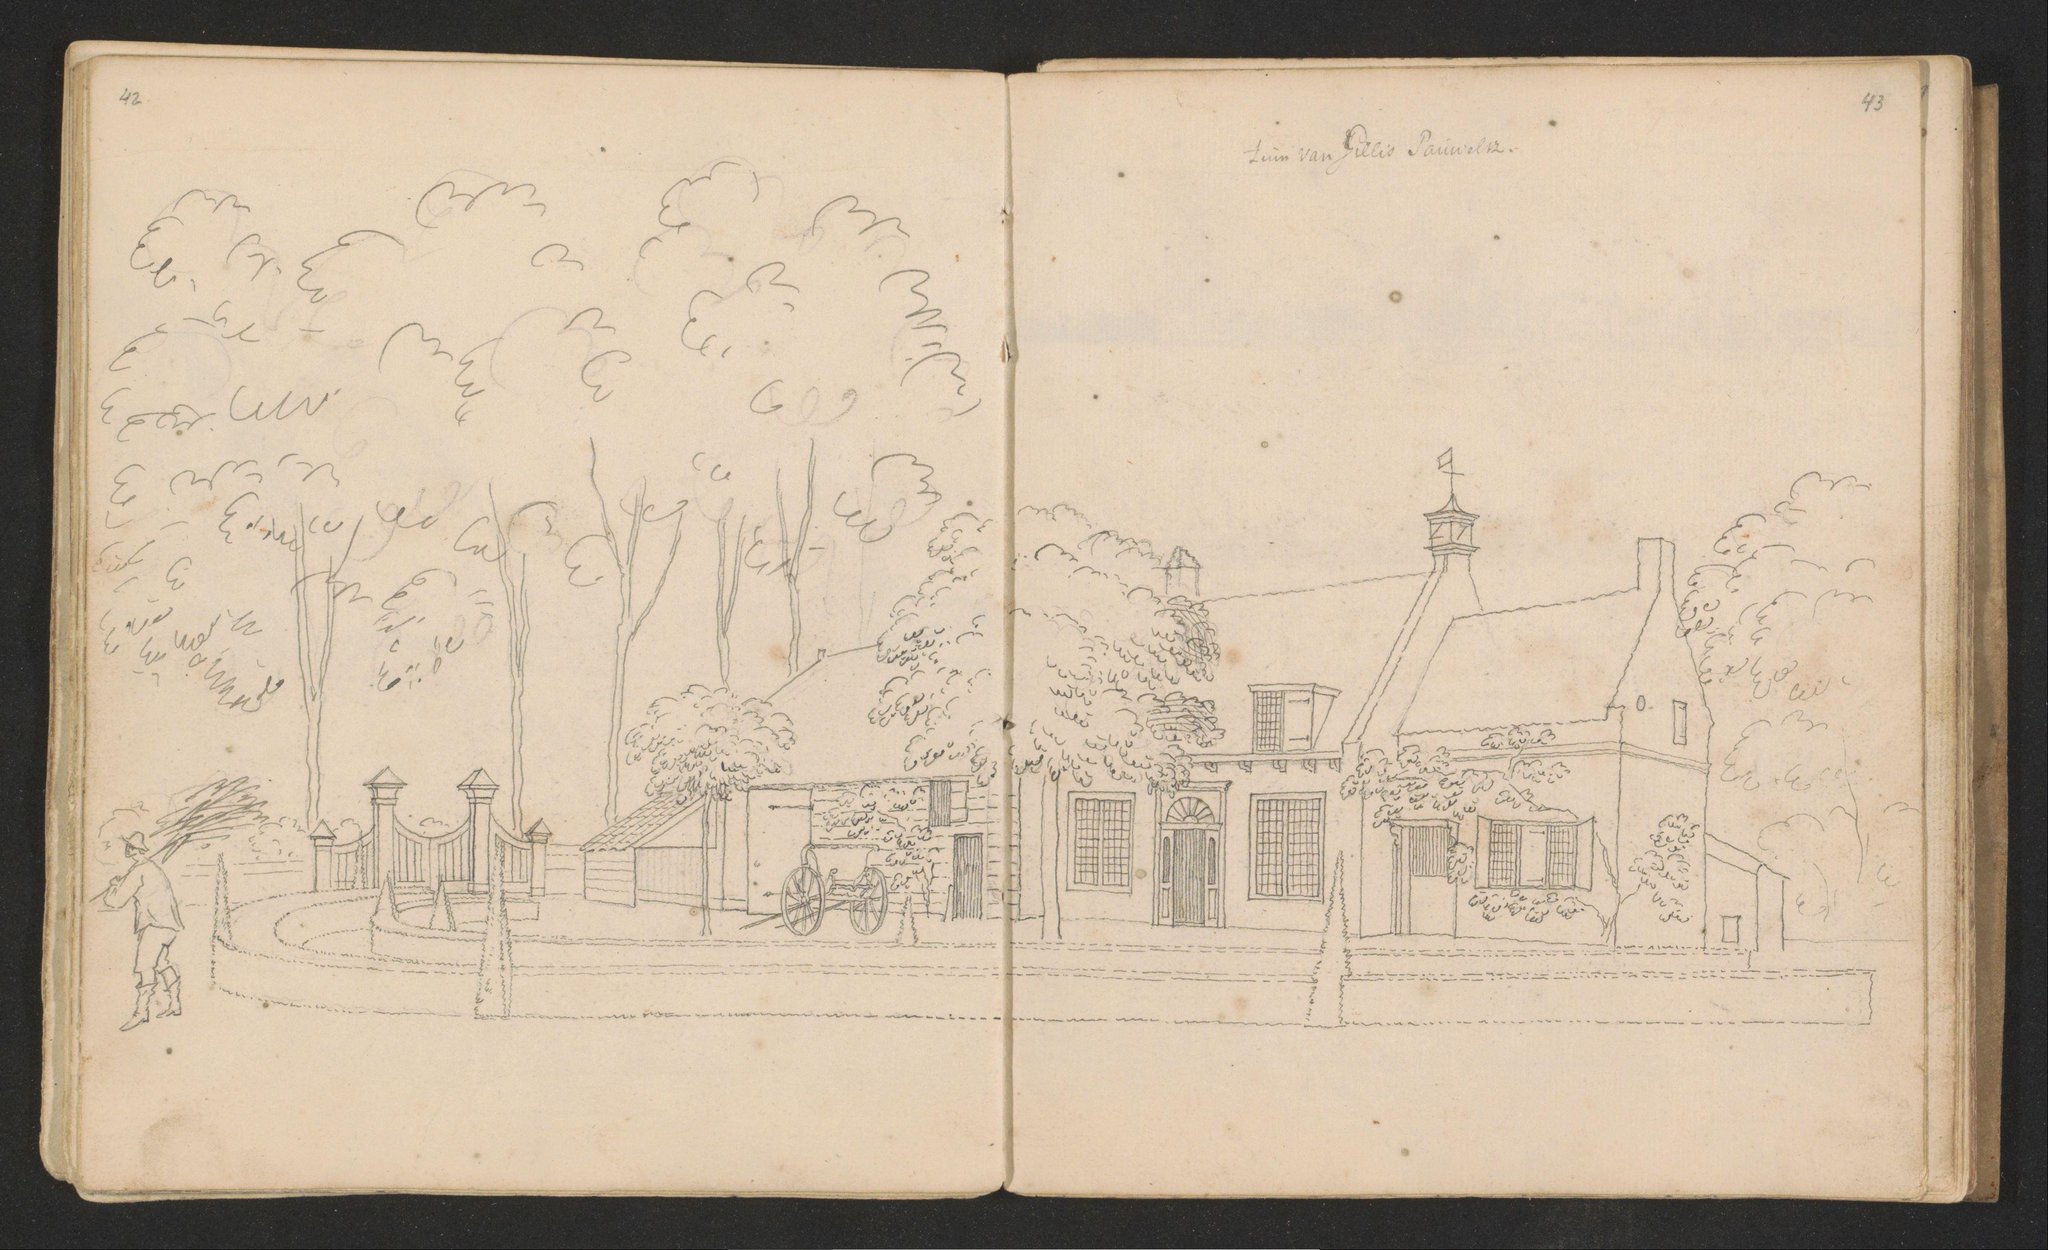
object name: sketchbook leaf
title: Huis en tuin van Gillis Pauwelsz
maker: cornelis pronk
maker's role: draughtsman, painter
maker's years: 1691-1759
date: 1728-1732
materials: ink, paper, pencil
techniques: pen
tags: garden, farm or solitary house in landscape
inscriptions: annotation: ‘Tuin van Gillis Pauwelsz’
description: Tuin met in model geknipte heggen en een toegangshek. Voor het huis staat een open rijtuig. Links loopt een man met gereedschap. Bladzijde 42 en 43 uit een schetsboek met 96 bladzijden.